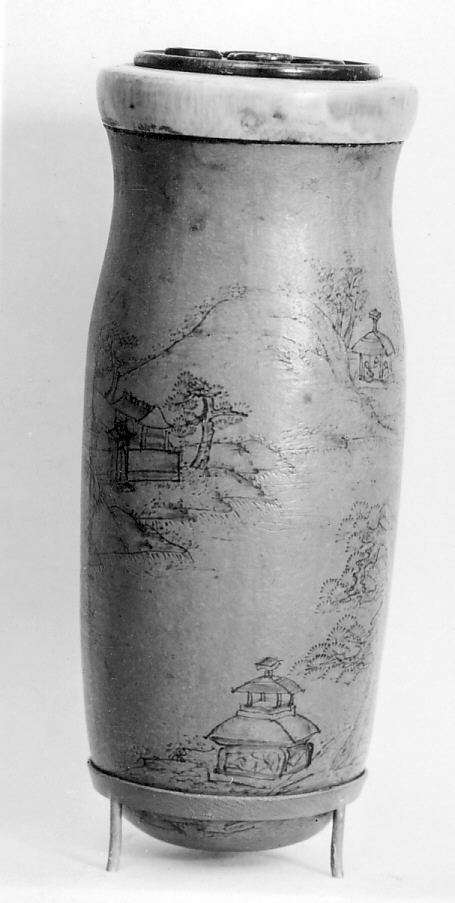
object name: cricket cage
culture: chinese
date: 1701-1900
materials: ivory